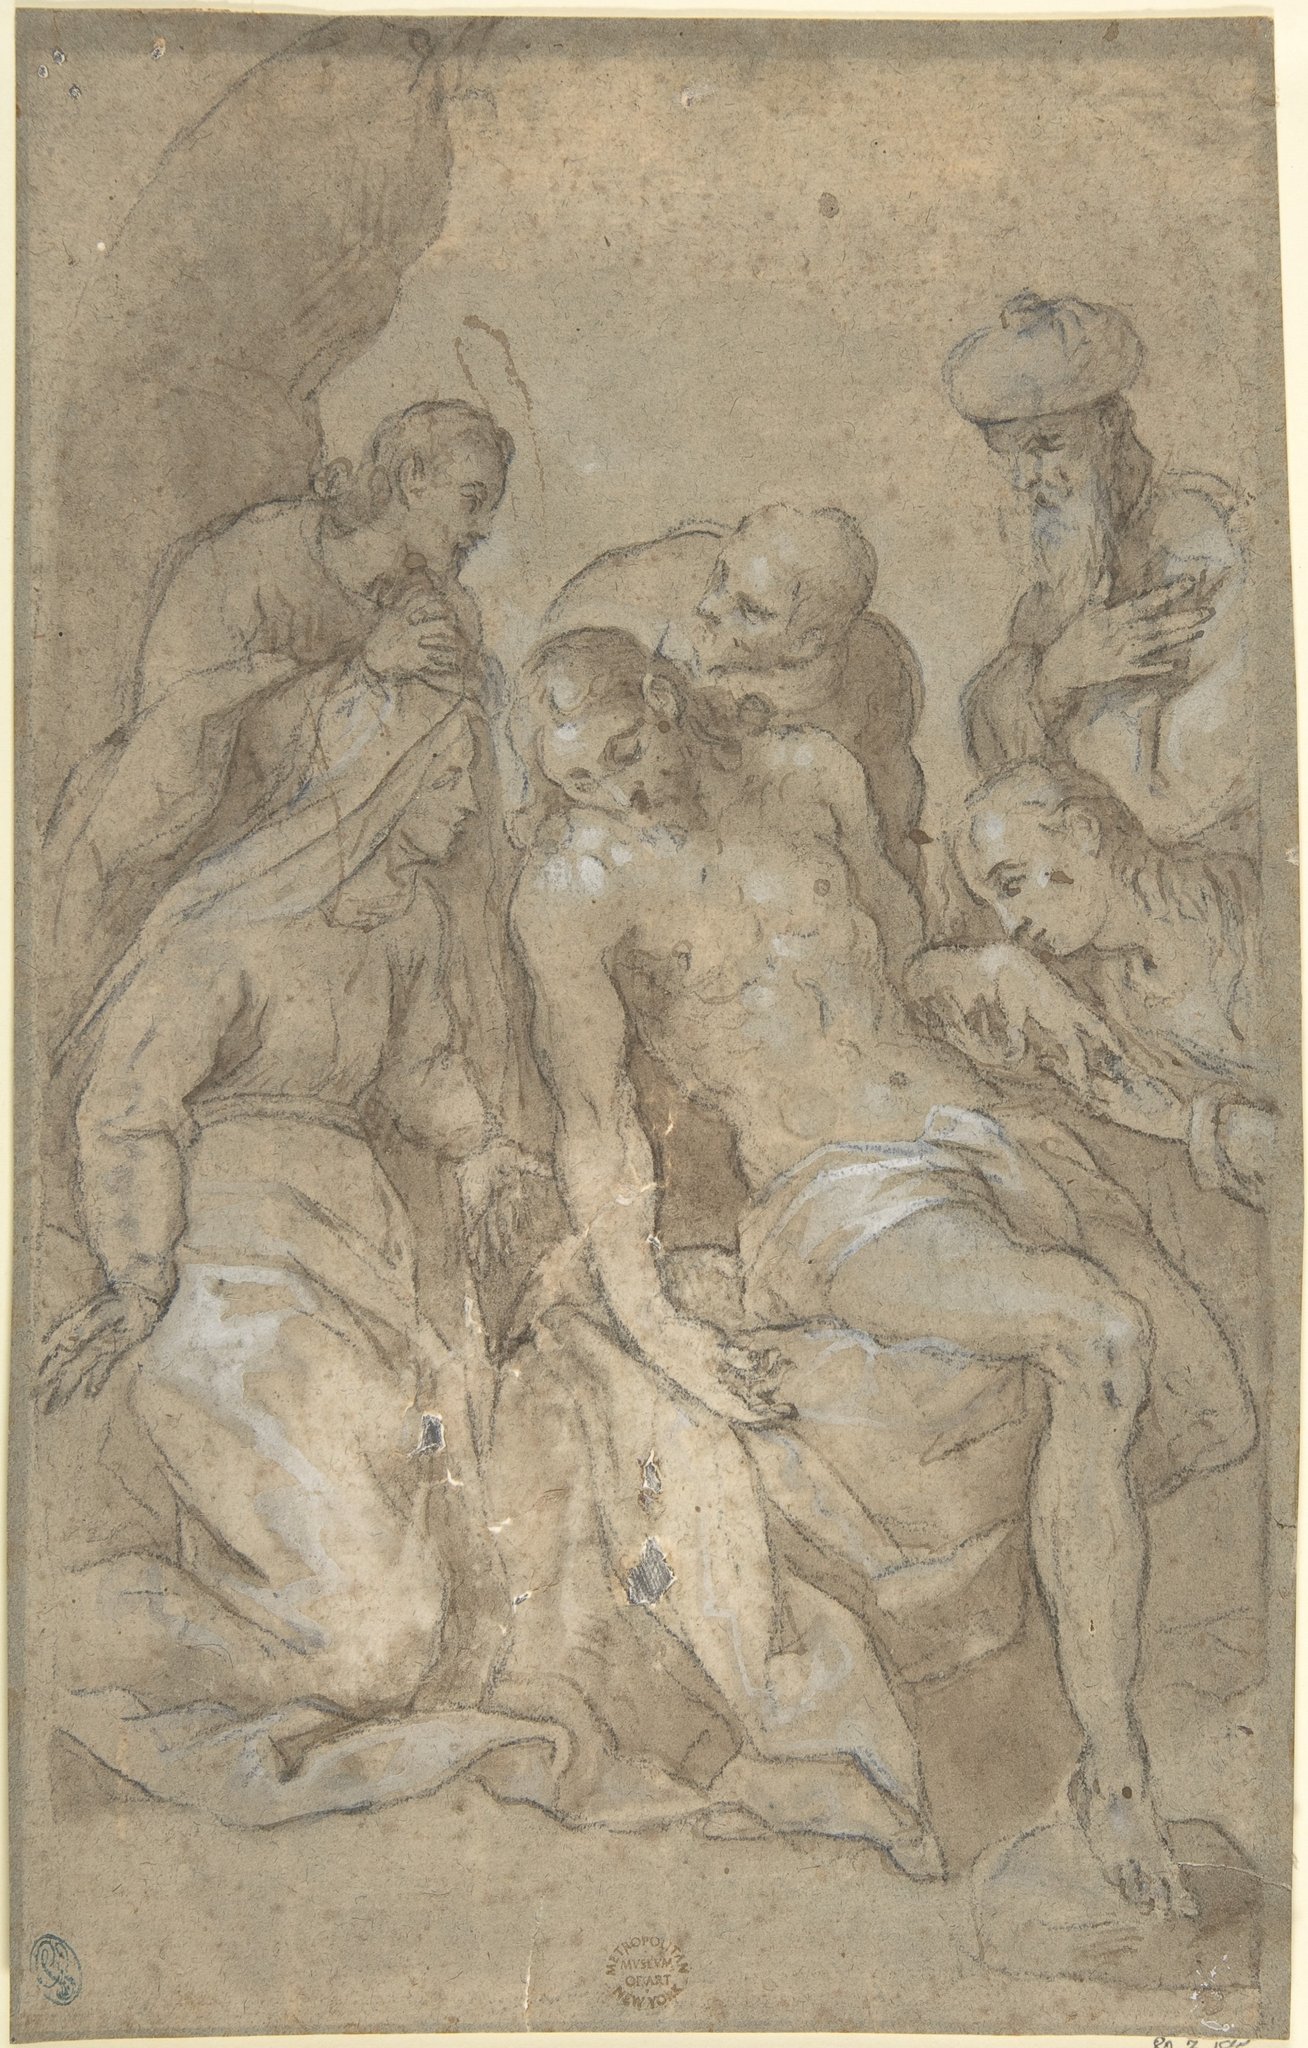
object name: drawing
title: The Entombment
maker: anonymous, italian, 16th century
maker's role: artist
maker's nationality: italian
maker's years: 1550-1600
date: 1501-1600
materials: chalk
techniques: brush, wash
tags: women,christ,entombment